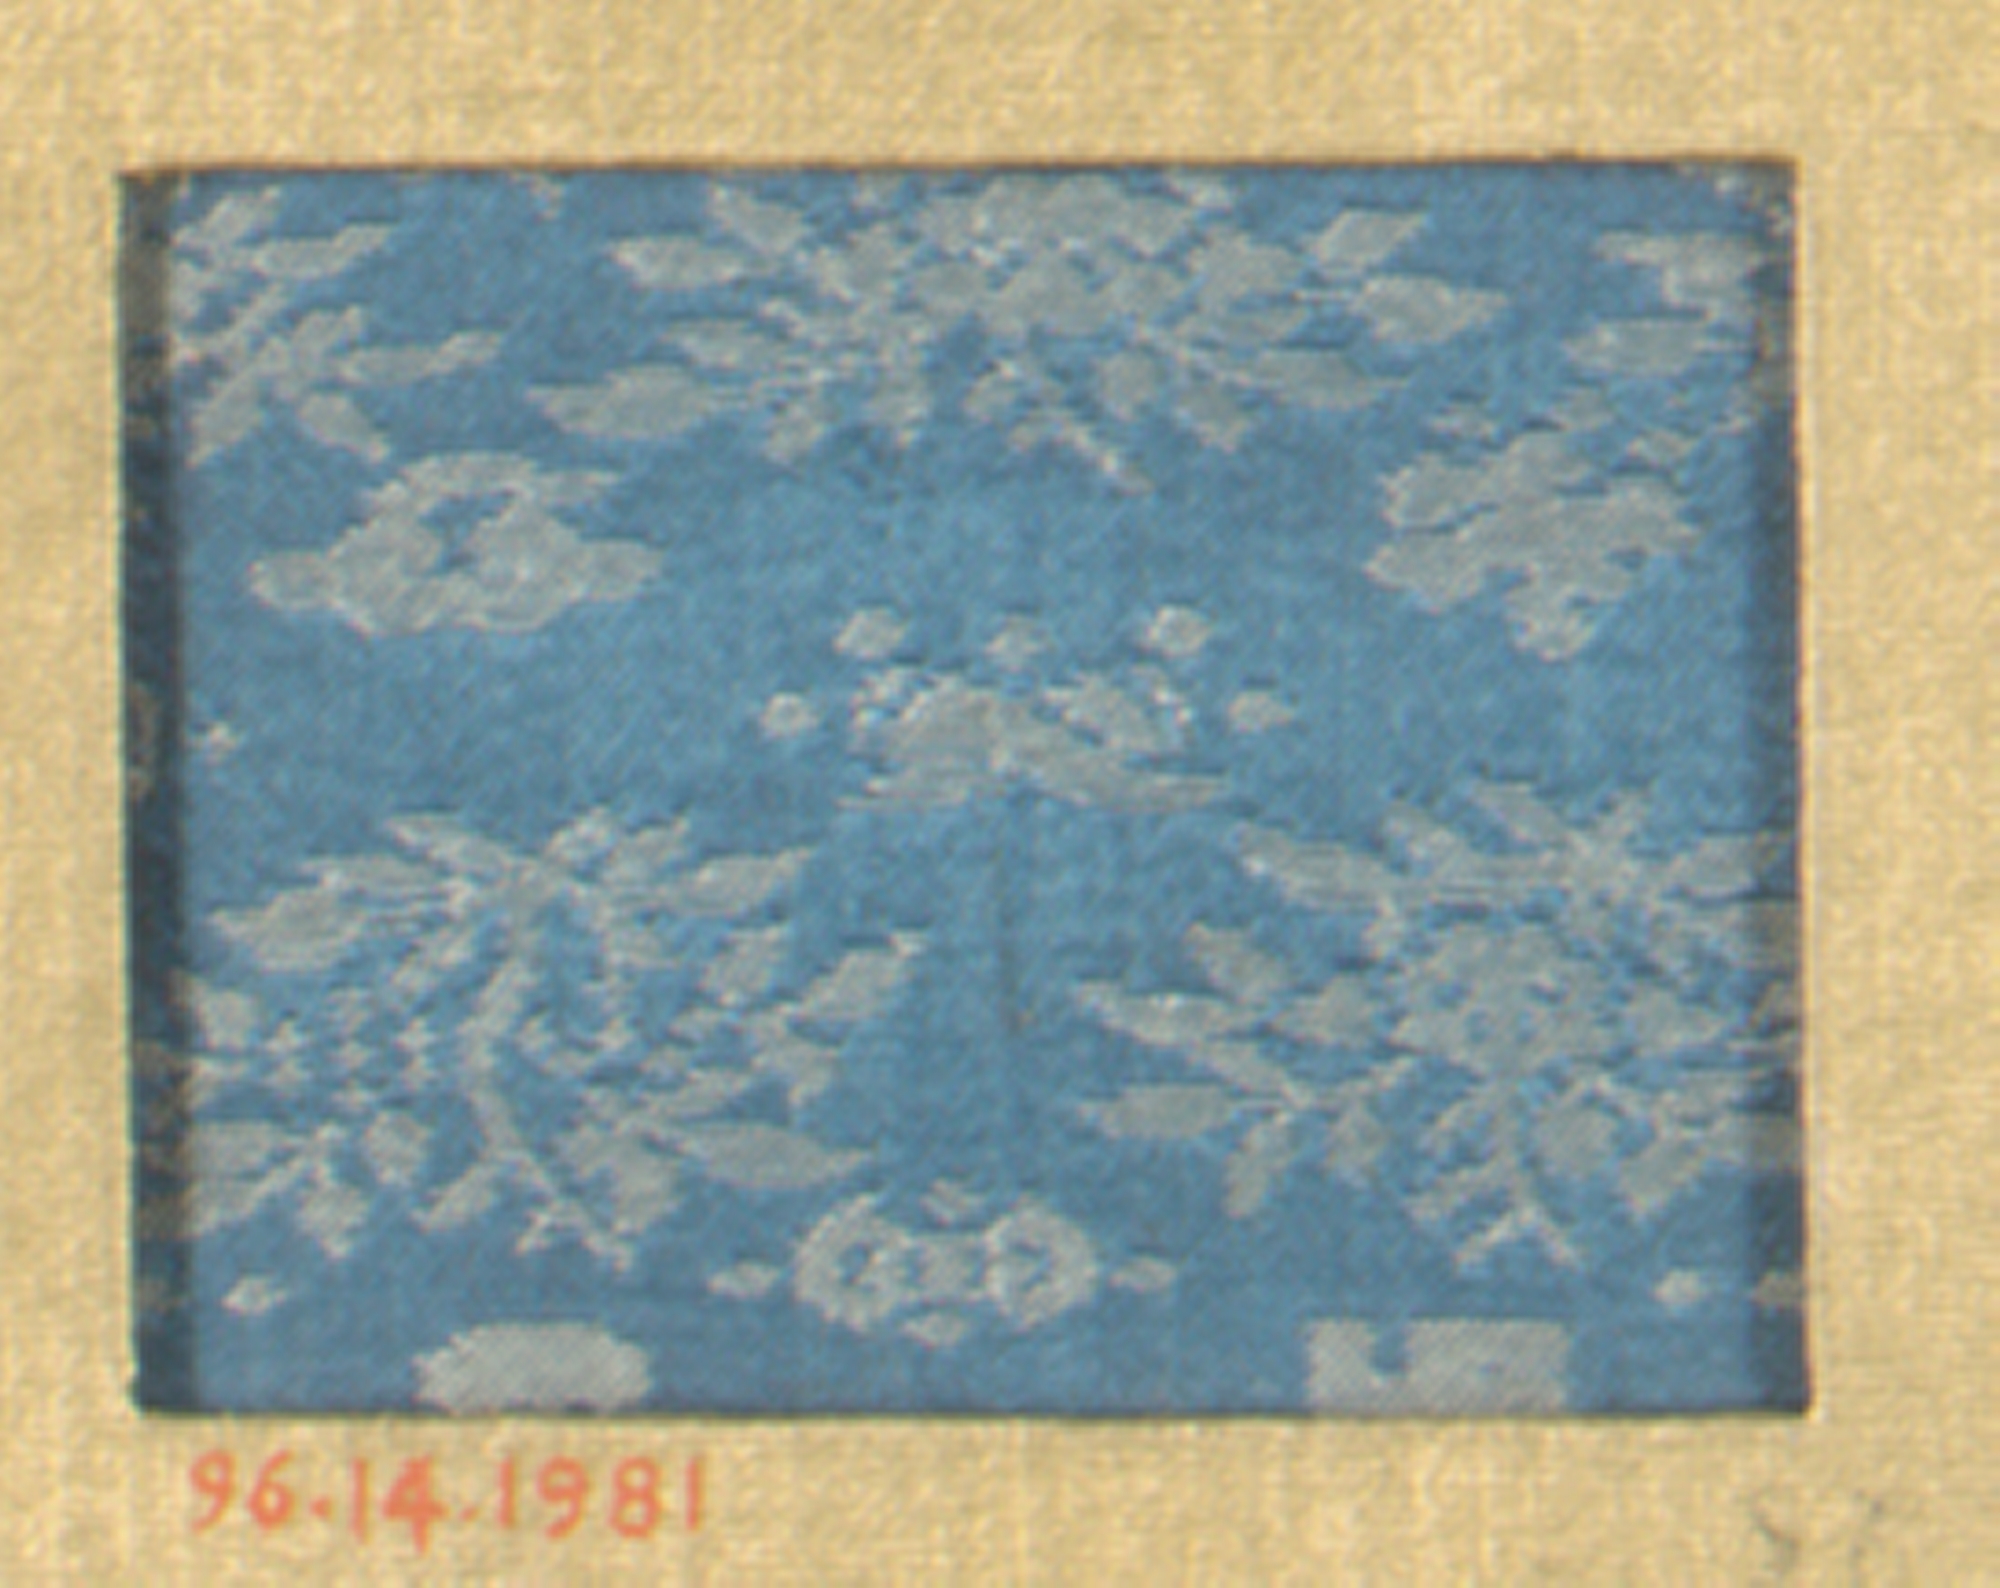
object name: piece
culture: japanese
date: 1701-1900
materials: silk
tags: flowers